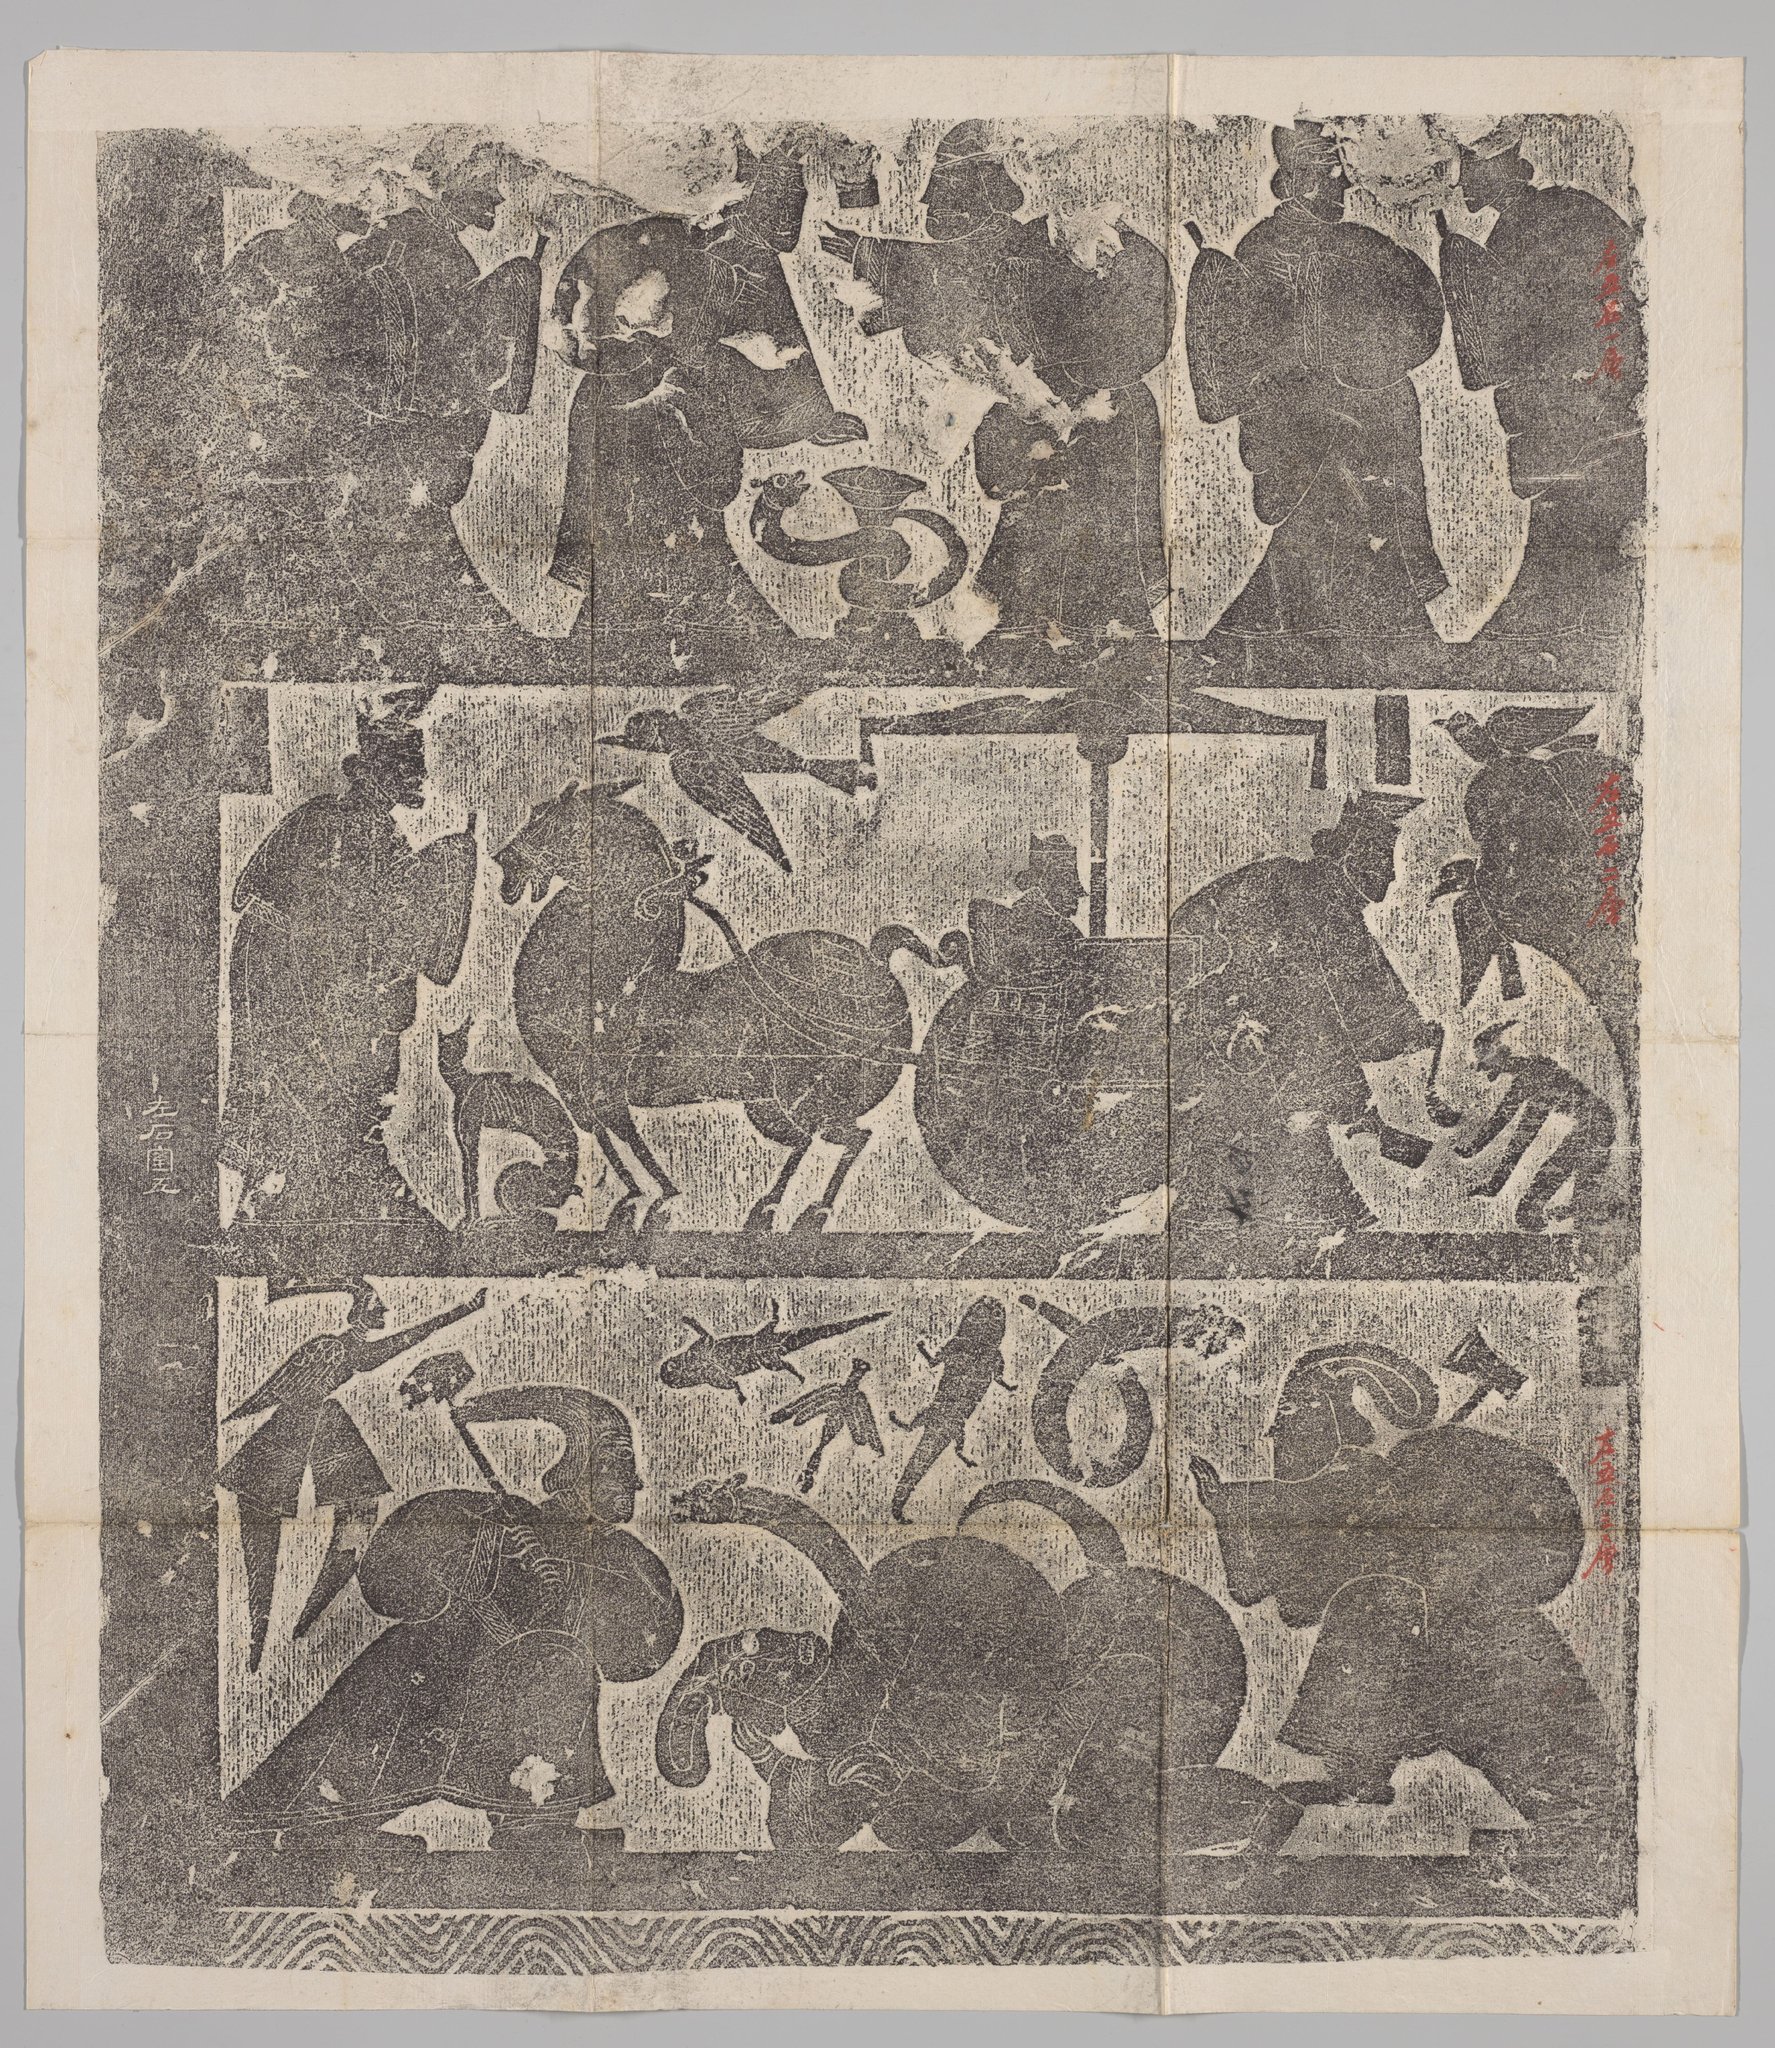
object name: wrijfprent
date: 1900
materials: ink, paper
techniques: rubbing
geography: china